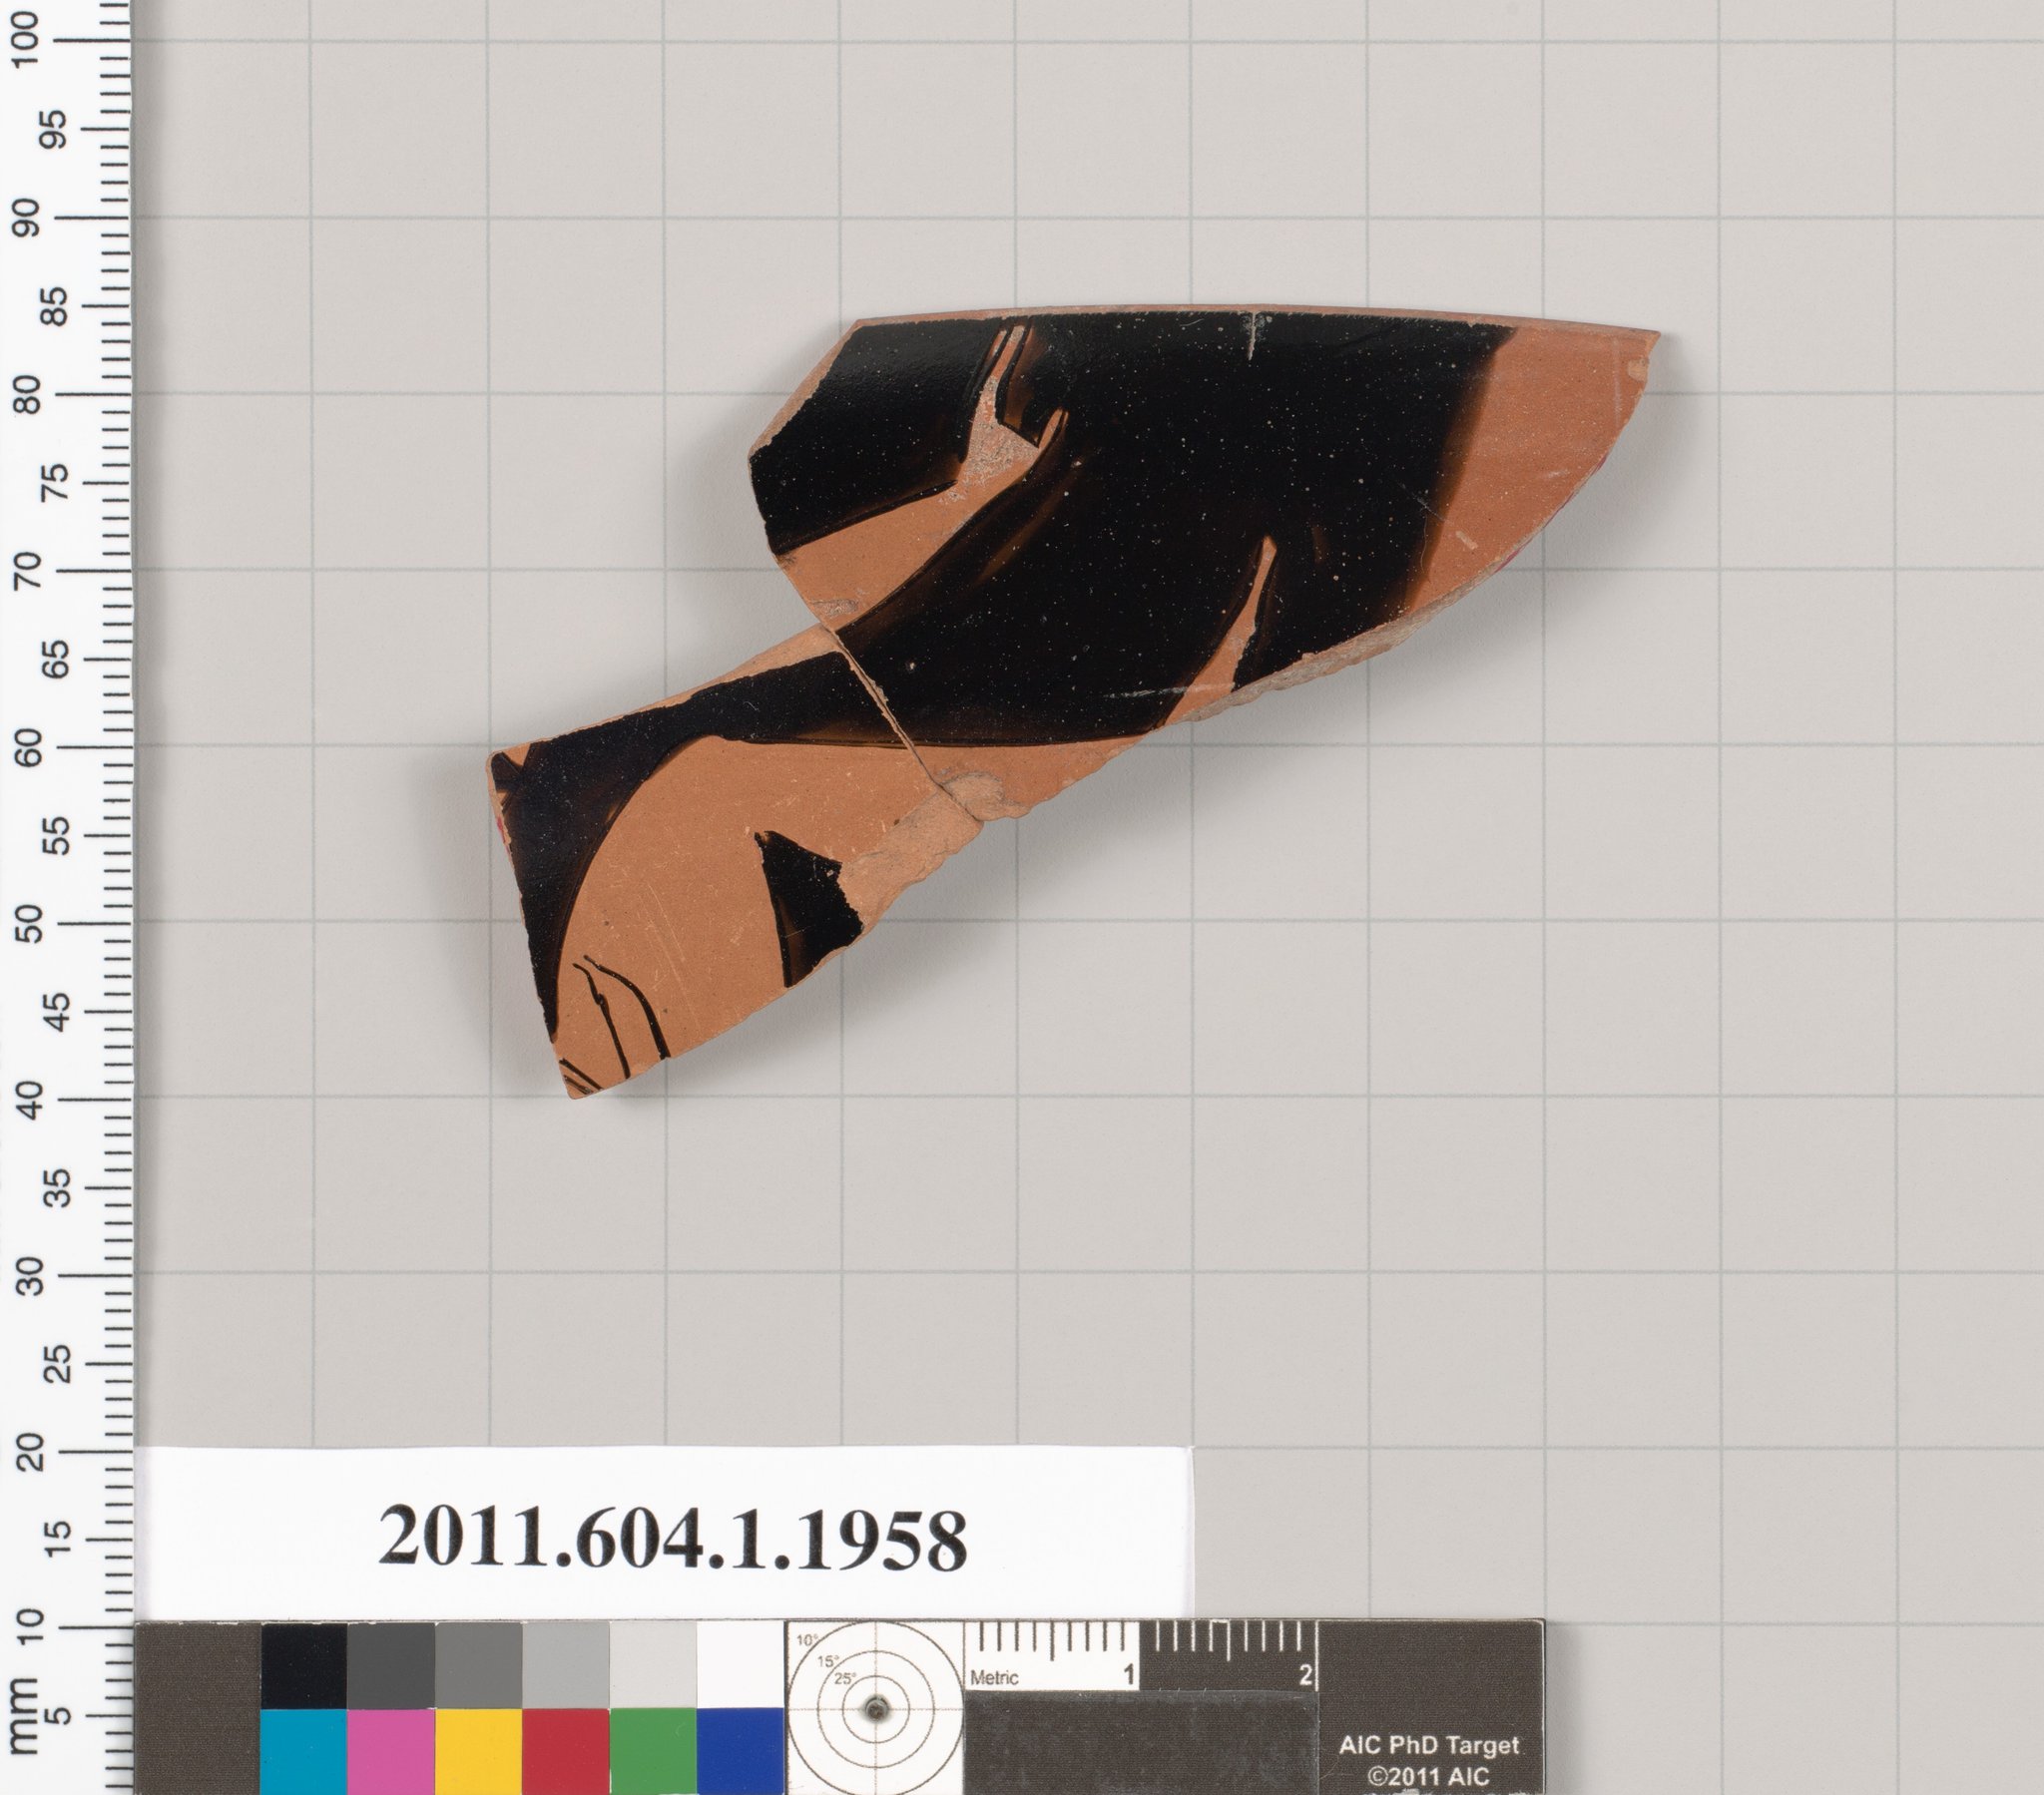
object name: kylix fragment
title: Terracotta rim fragment of a kylix (drinking cup)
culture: greek, attic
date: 490-480 BCE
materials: terracotta